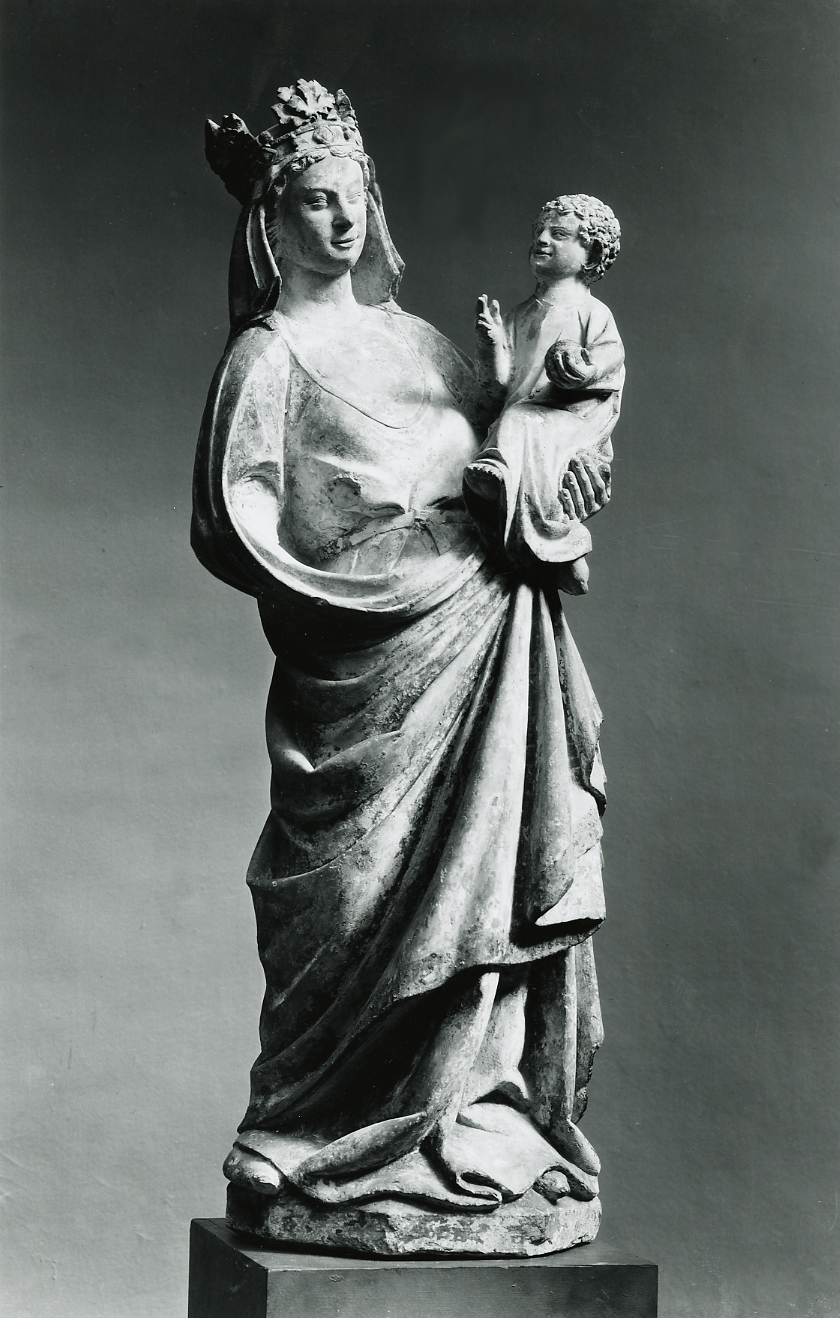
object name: statue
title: Virgin and Child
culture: french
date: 1267-1333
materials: gilt, stone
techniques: polychrome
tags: madonna and child